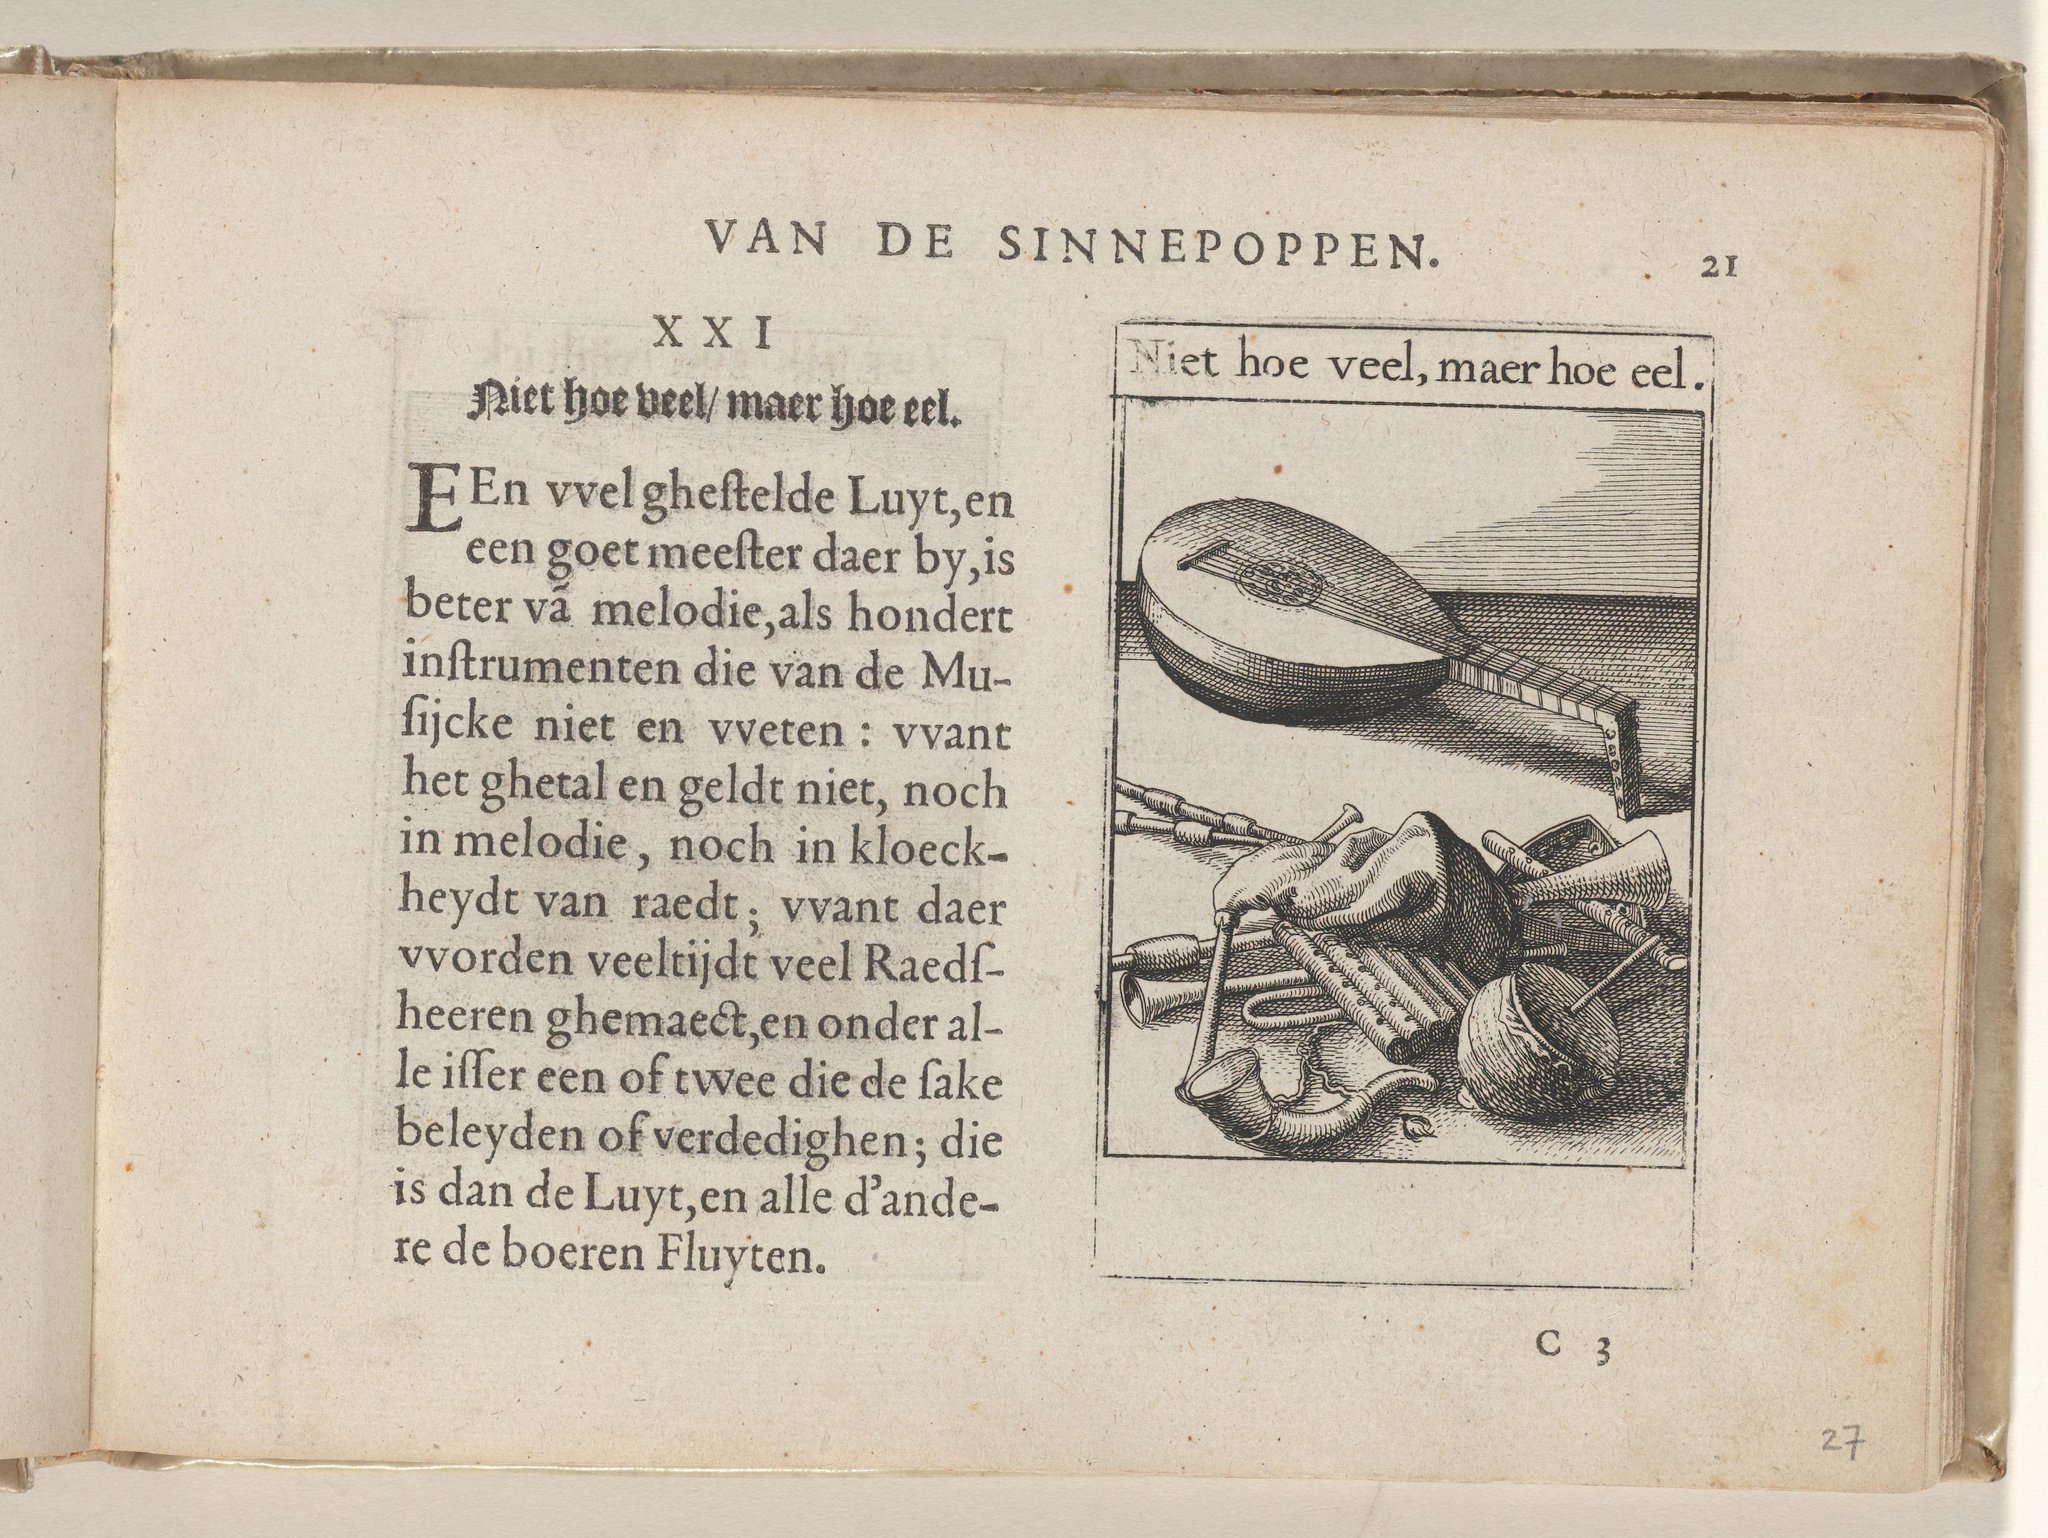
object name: album leaf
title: XXI Niet hoe veel, maer hoe eel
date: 1614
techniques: engraving, printing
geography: amsterdam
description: XXI Niet hoe veel, maer hoe eel. Eerste schok. Onderdeel van 'Sinnepoppen', R. Visscher, 1614.